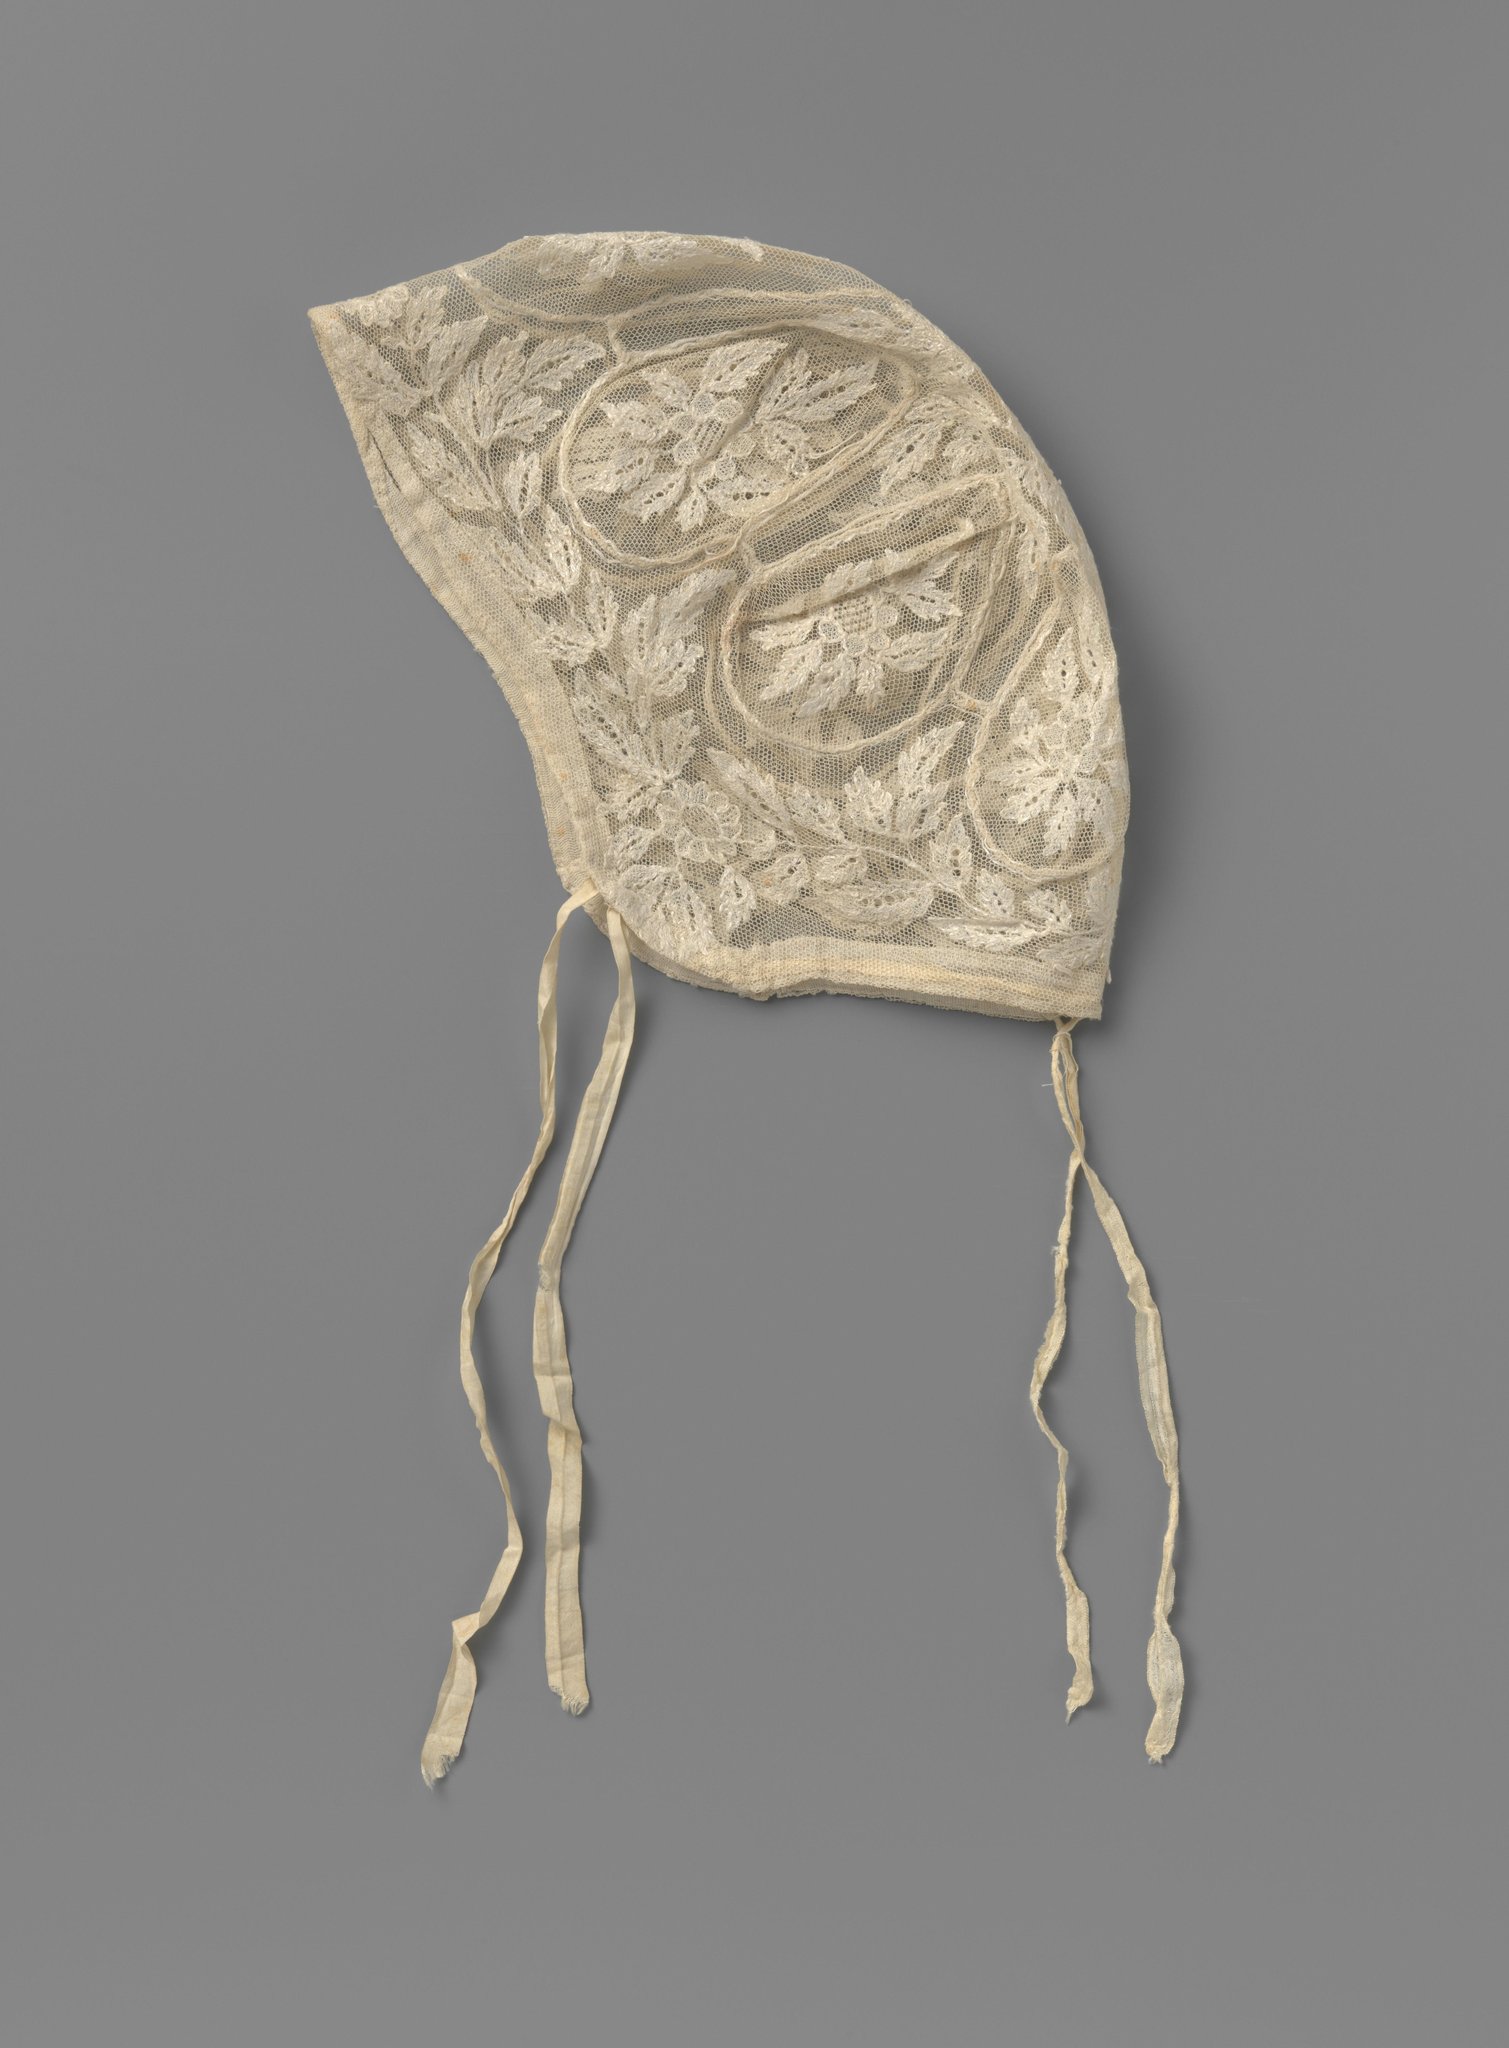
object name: cap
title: Muts van kantborduurwerk op tule met bloemtakken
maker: Anonymous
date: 1900-1924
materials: linen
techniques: embroidered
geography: north holland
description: Muts van naturelkleurig kantborduurwerk: tuledoorstopwerk op machinale tule. Zeven peervormige pattes zijn ingezet in de muts van tule. Het midden en de zeven inzetstukken zijn versierd met een anemoon, die straalsgewijs door blaadjes is omgeven. De rand is geheel gevuld met een dunne tak met dezelfde bloemen en bladeren.